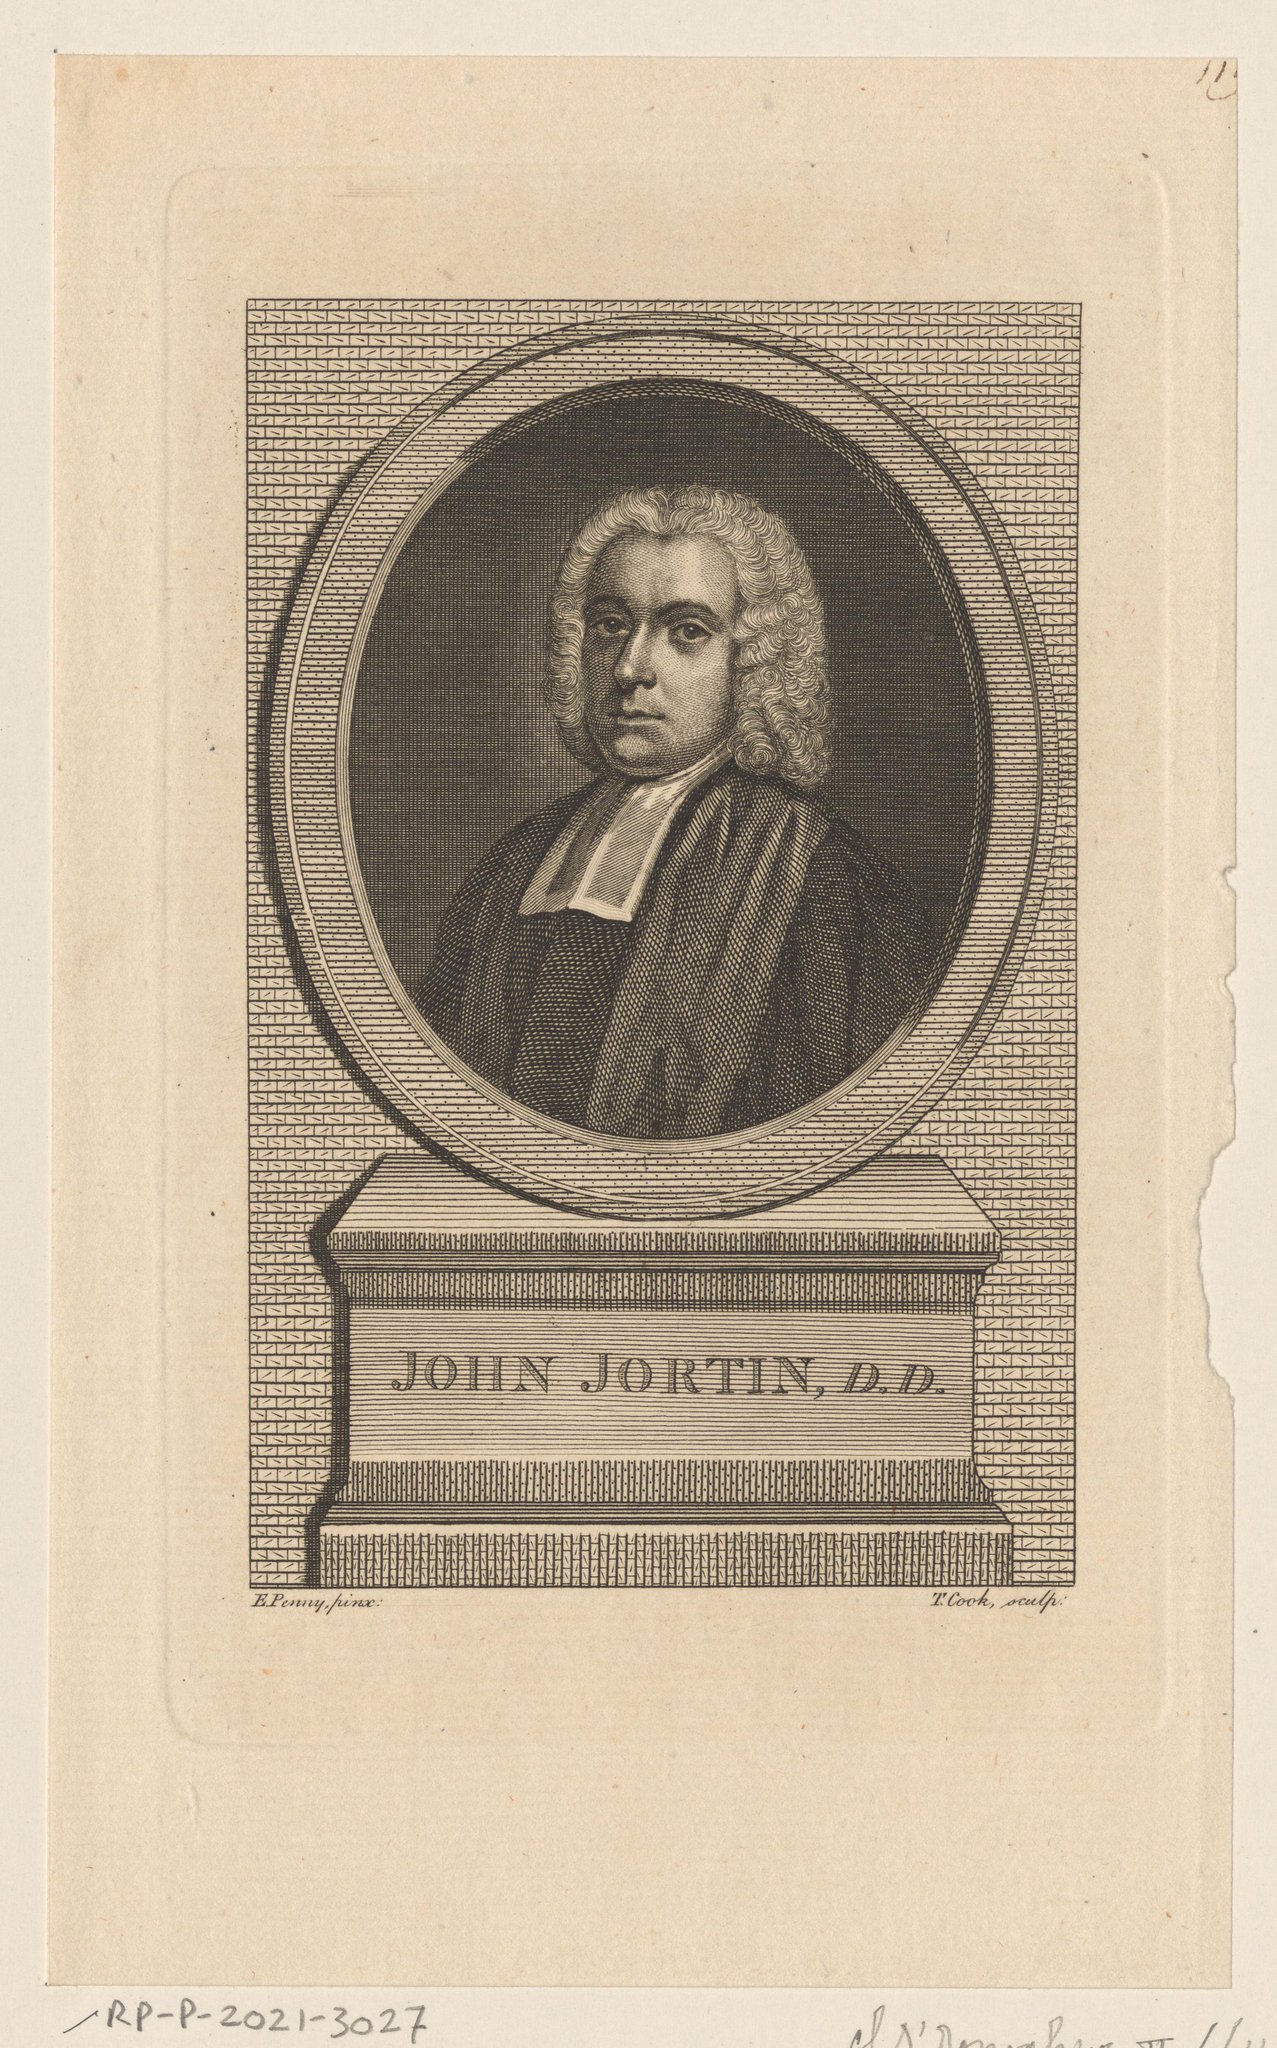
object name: print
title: Portret van John Jortin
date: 1754-1818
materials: paper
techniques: engraving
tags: historical persons, portrait of a writer